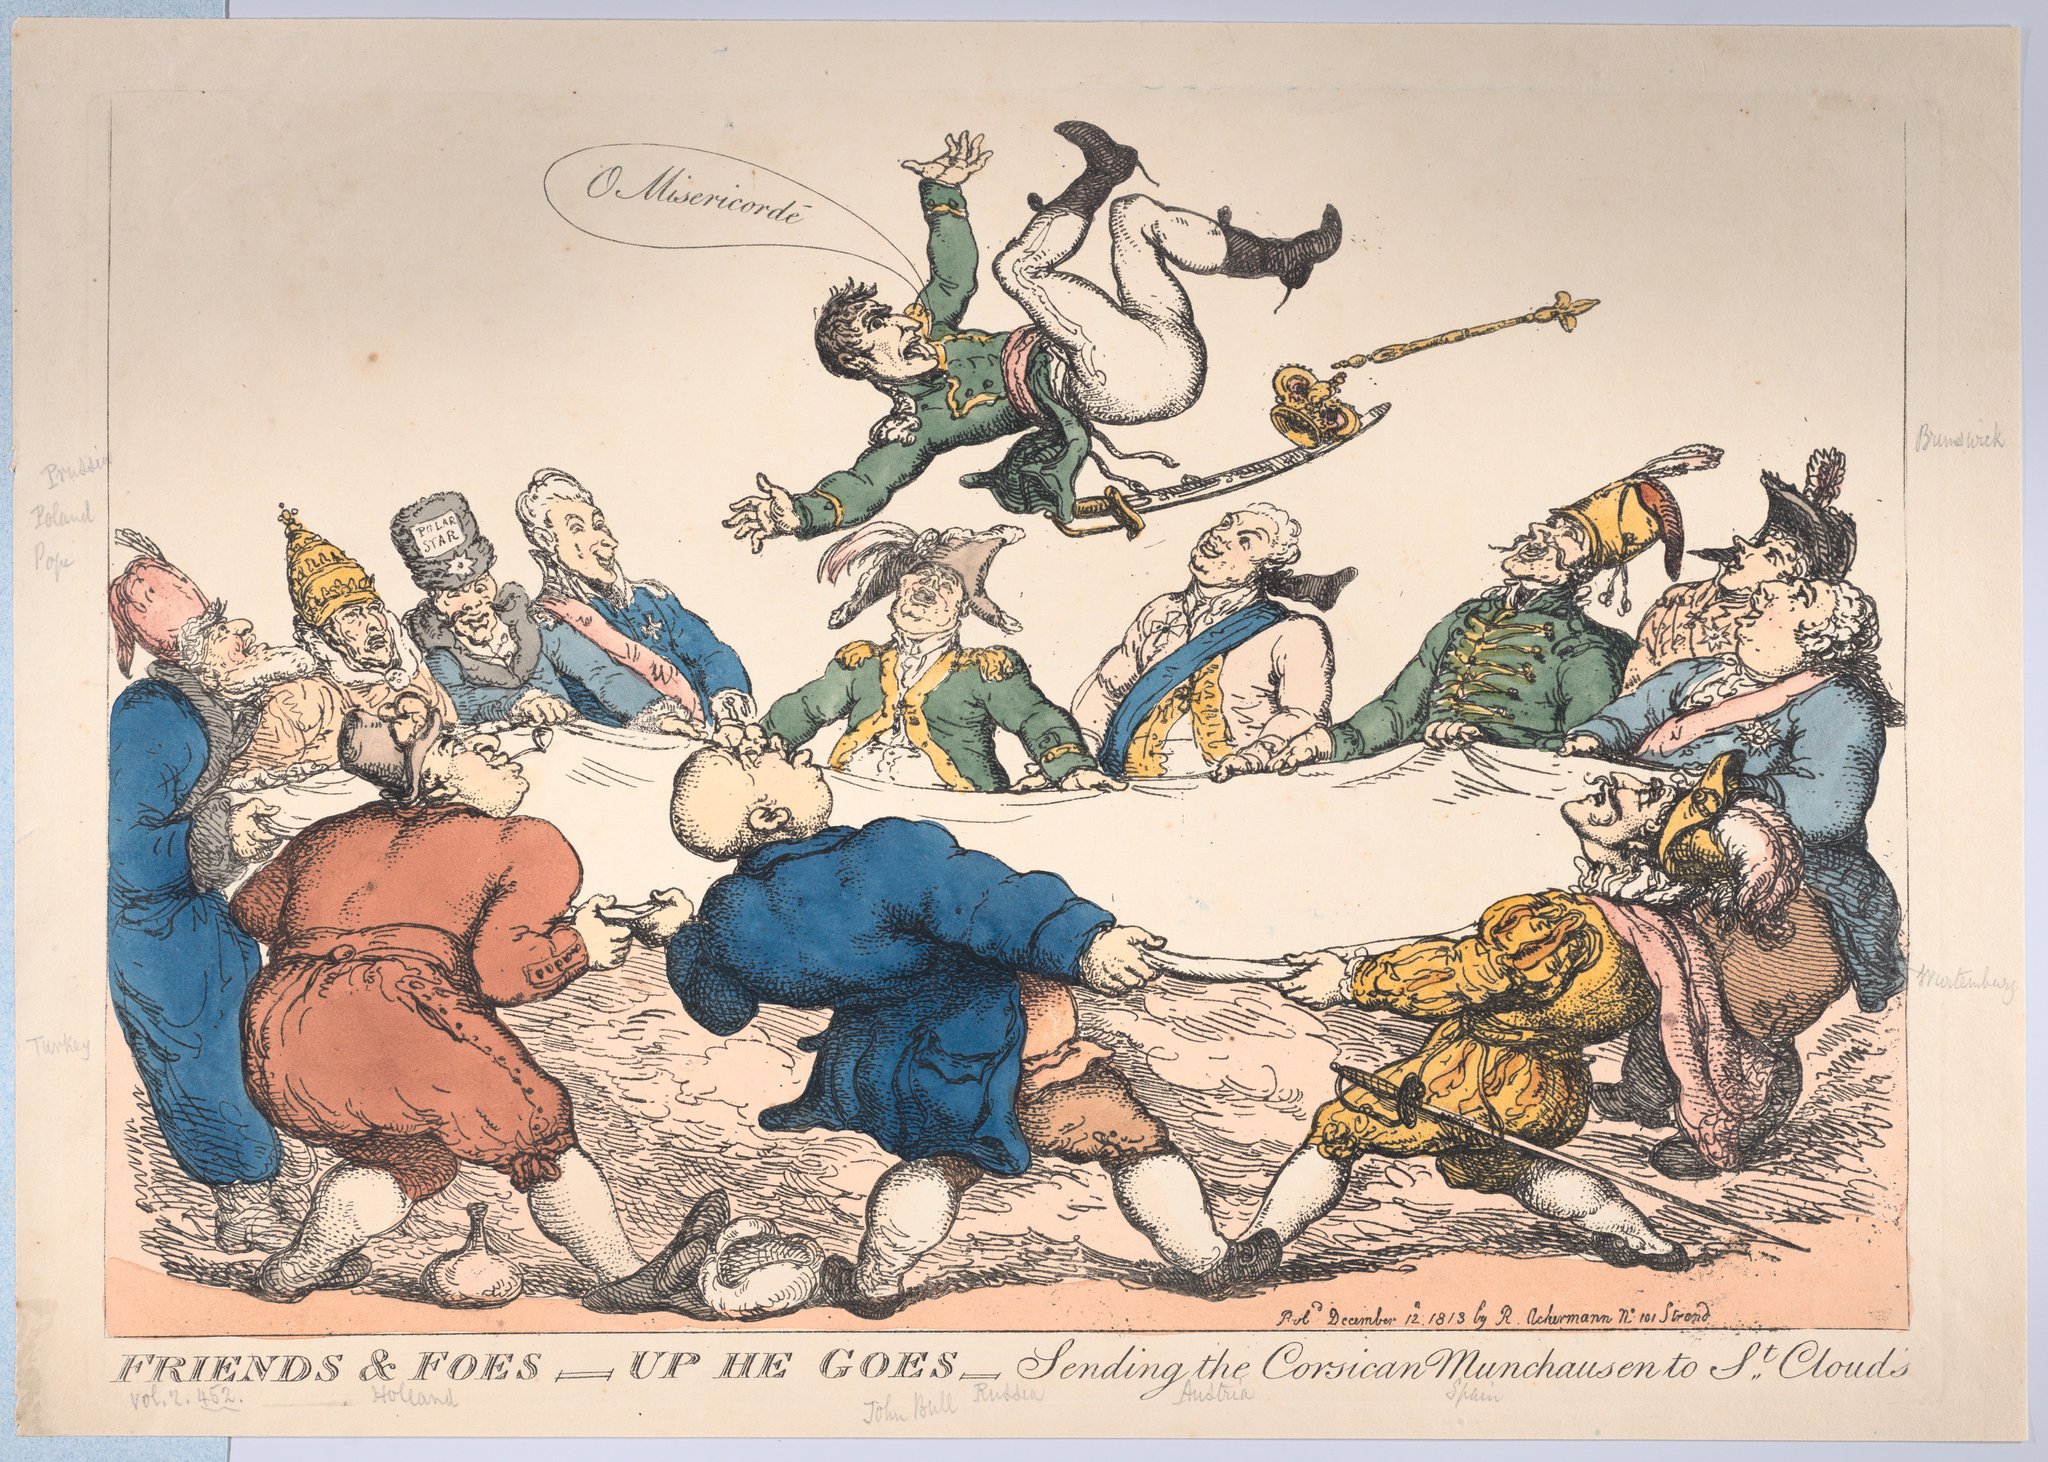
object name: print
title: Friends and Foes–Up He Goes–Sending the Corsican Munchausen to St. Cloud's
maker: thomas rowlandson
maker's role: artist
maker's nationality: british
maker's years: 1757-1827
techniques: etching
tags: satire,napoleon i,men,politics